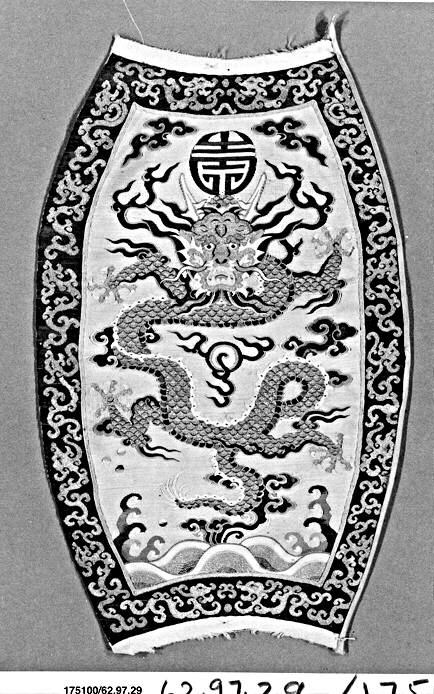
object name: panel for elbow pillow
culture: chinese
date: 1723-1735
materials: silk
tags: dragons